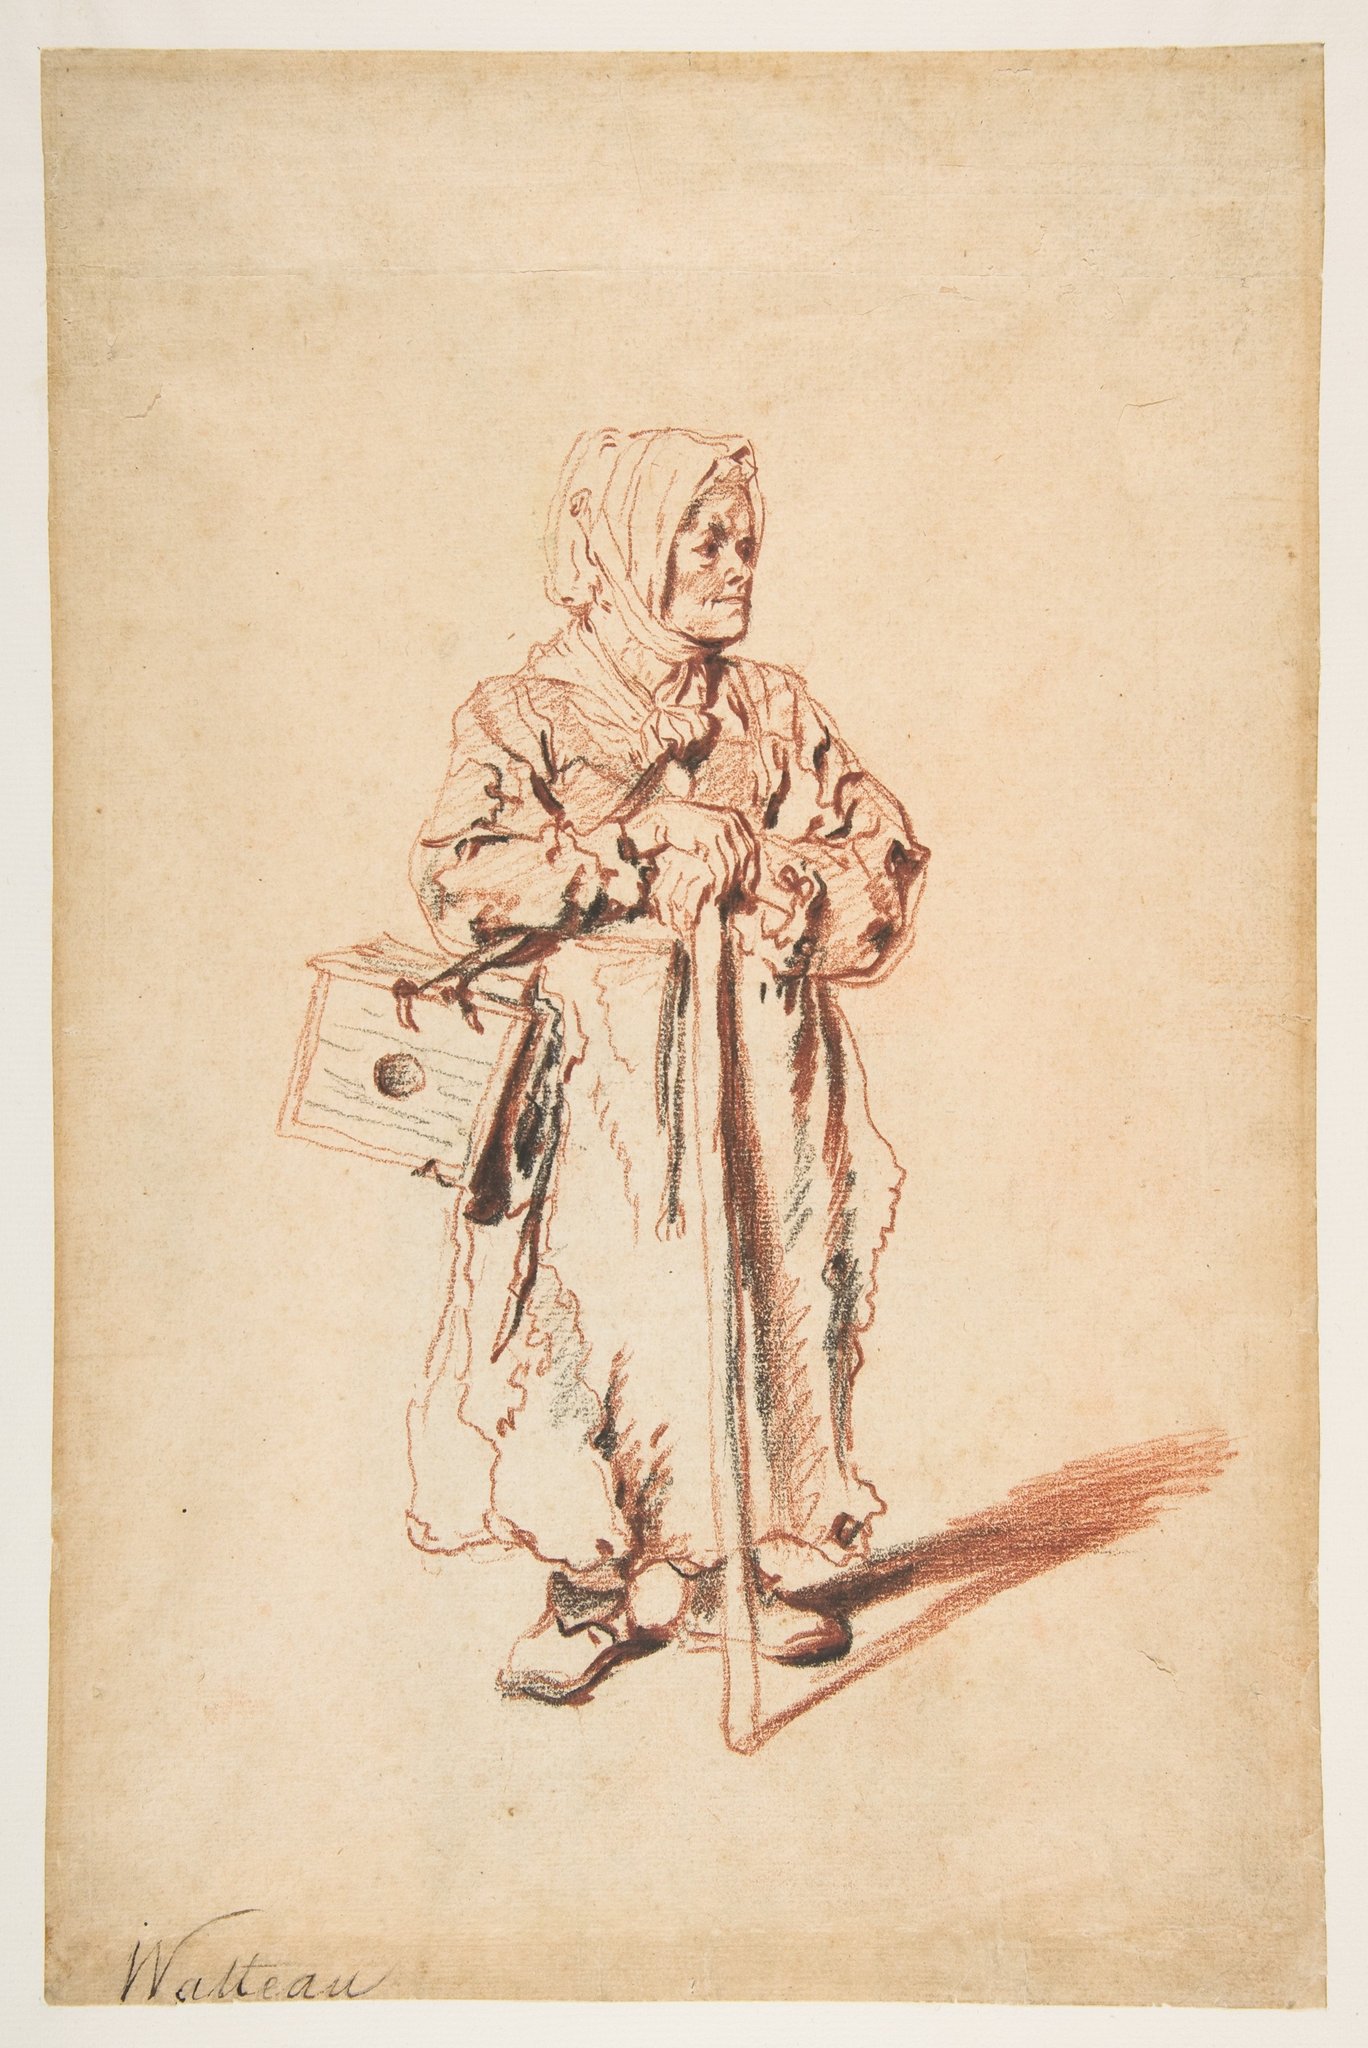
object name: drawing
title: Standing Savoyarde with a Marmot Box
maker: antoine watteau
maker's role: artist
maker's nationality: french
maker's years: 1684-1721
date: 1715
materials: chalk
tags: women